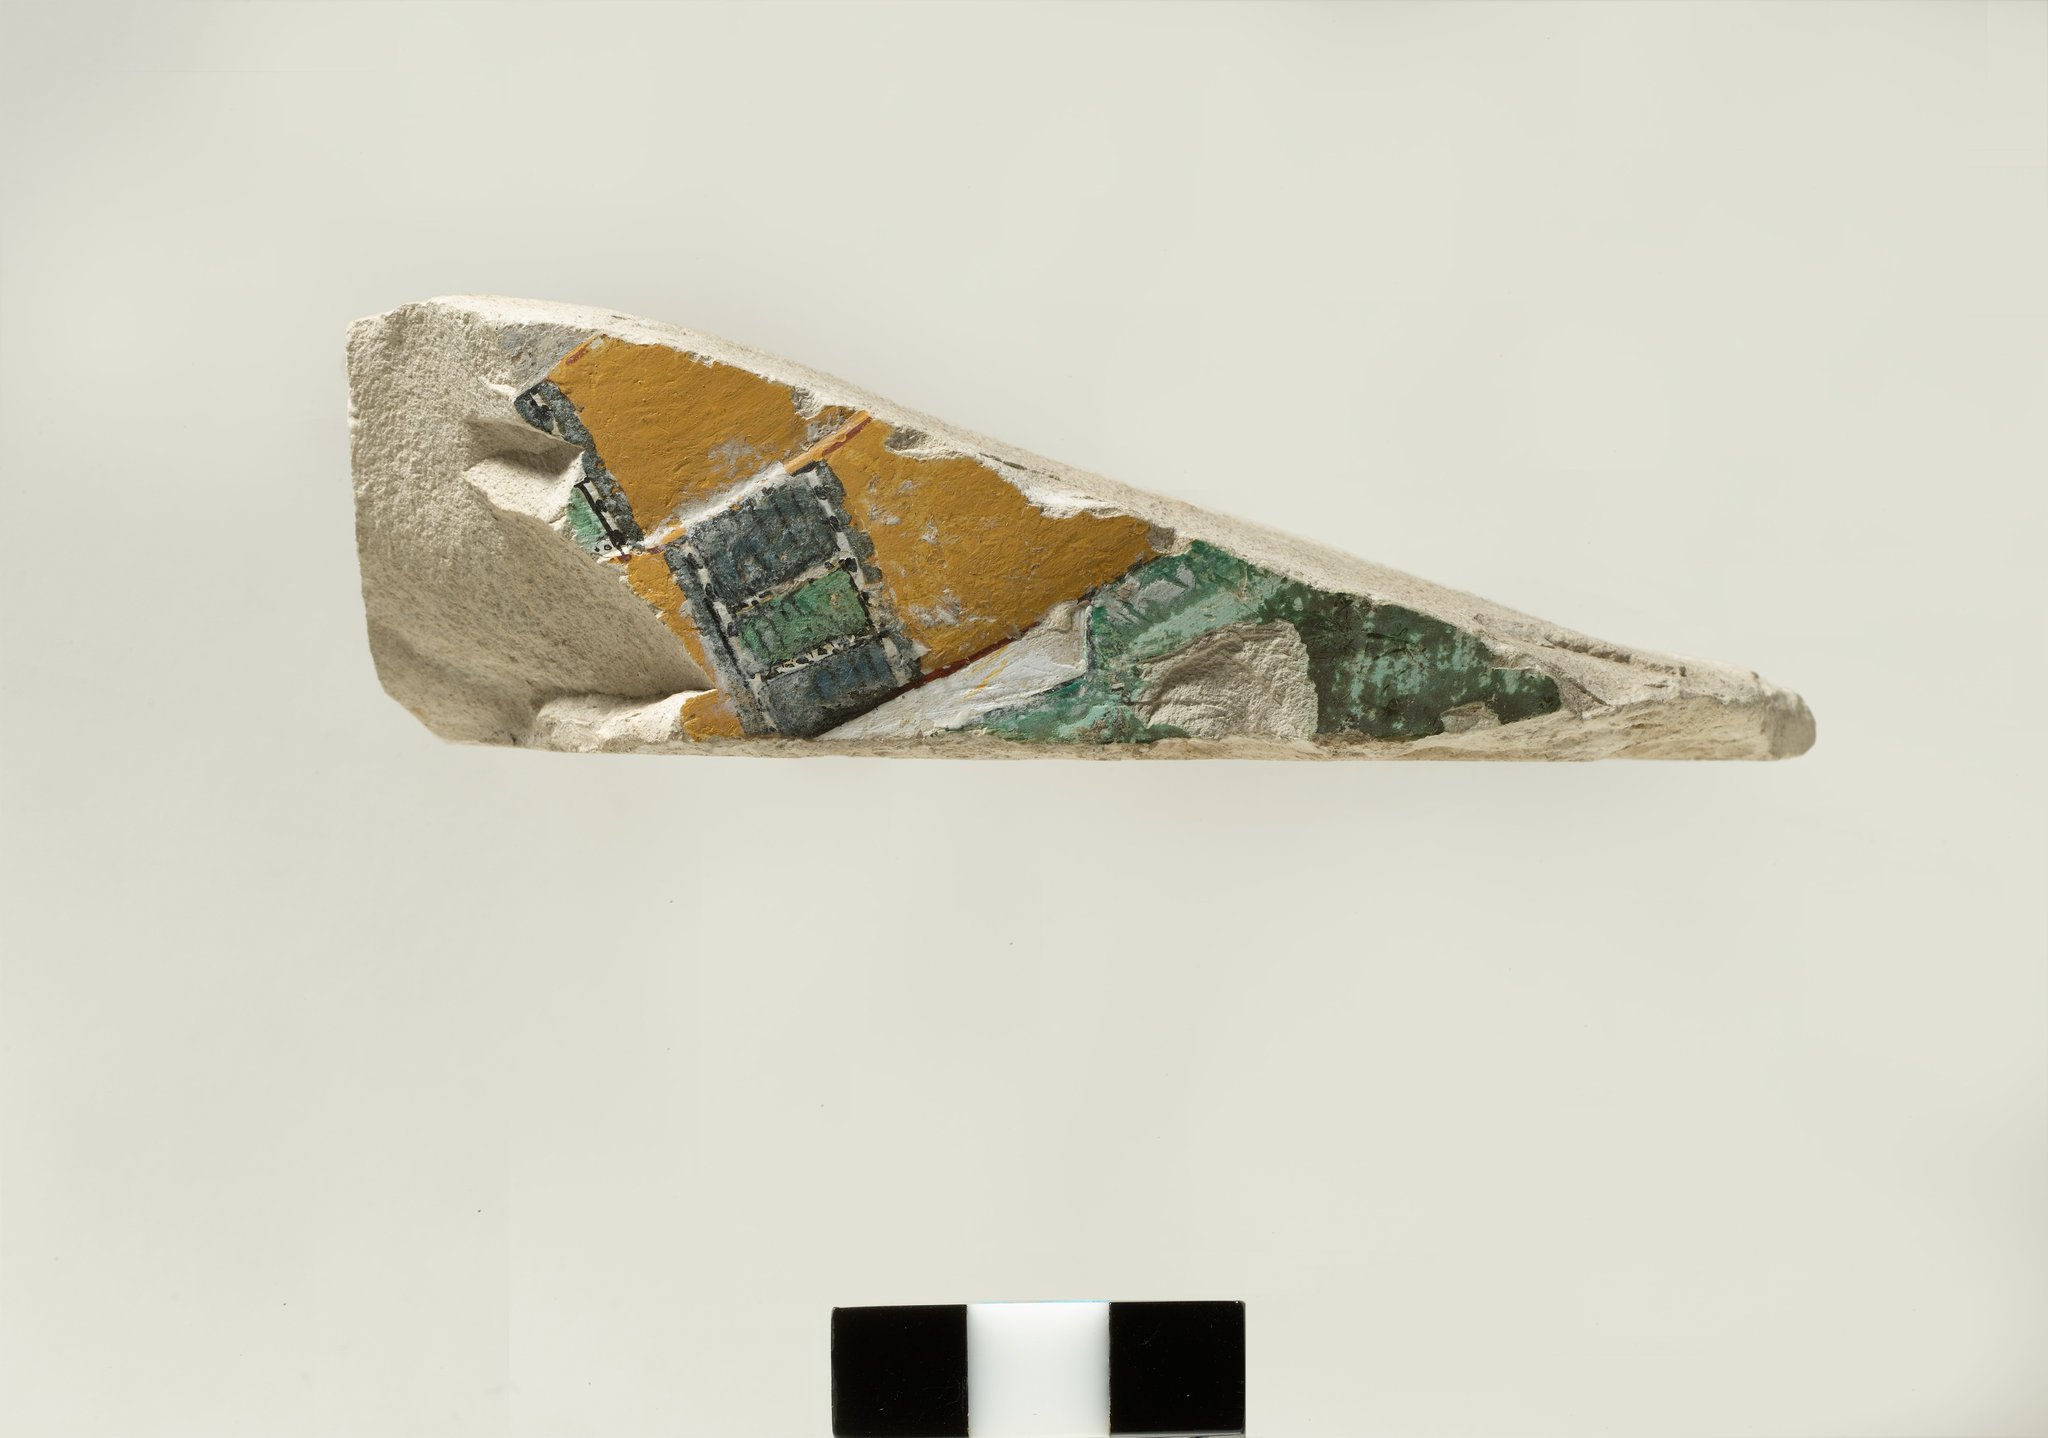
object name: relief fragment, tomb of meketre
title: Reliefs from the tomb of Meketre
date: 1981-1975 BCE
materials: limestone, paint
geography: egypt